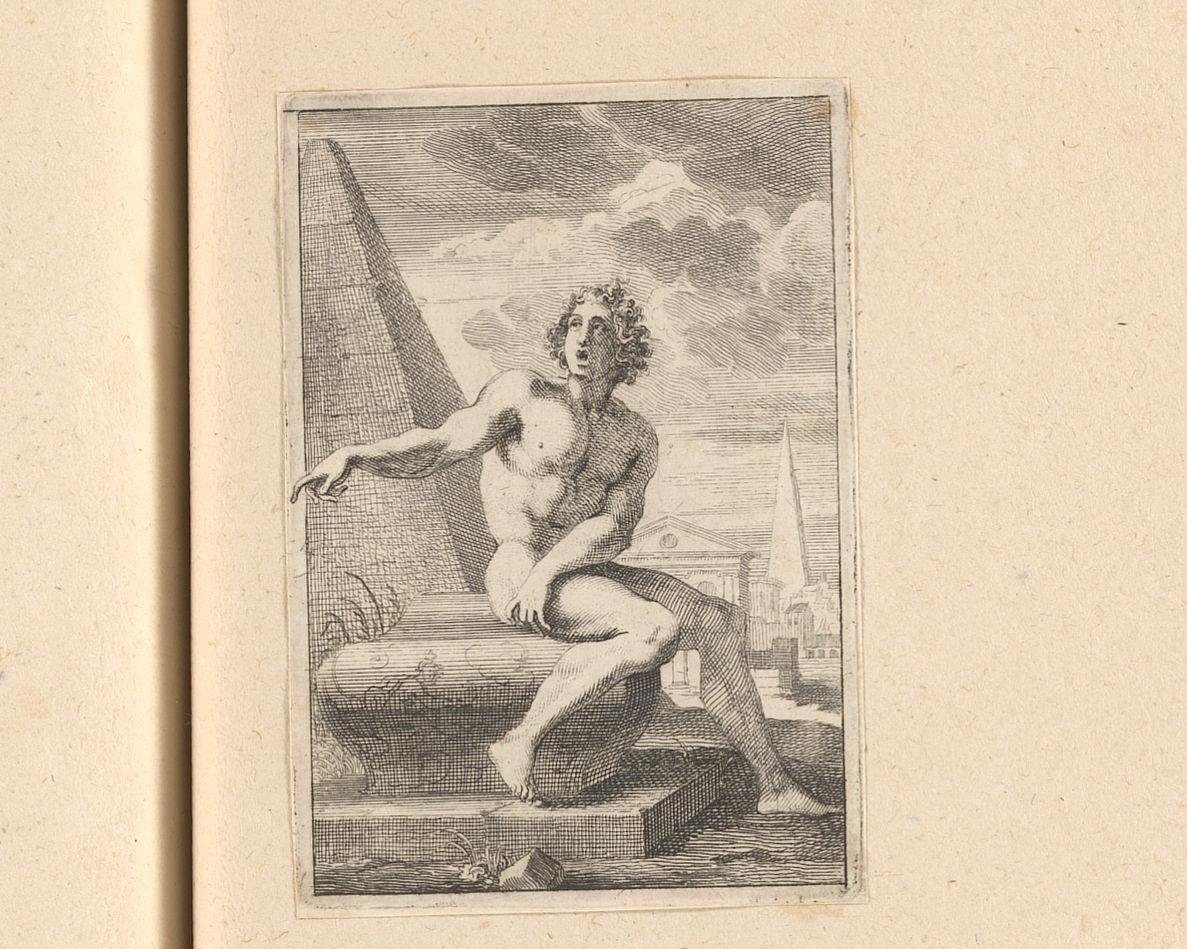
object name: print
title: Memnon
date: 1665-1673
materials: paper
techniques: etching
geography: paris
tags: model-books ~ implements of painter, (story of) memnon, son of aurora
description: Maakt deel uit van een 32-delige serie met tekenvoorbeelden van goden en helden uit de klassieke oudheid. Een eerste editie werd in 1673 uitgegeven en een tweede in 1684 door Nicolas Langlois.